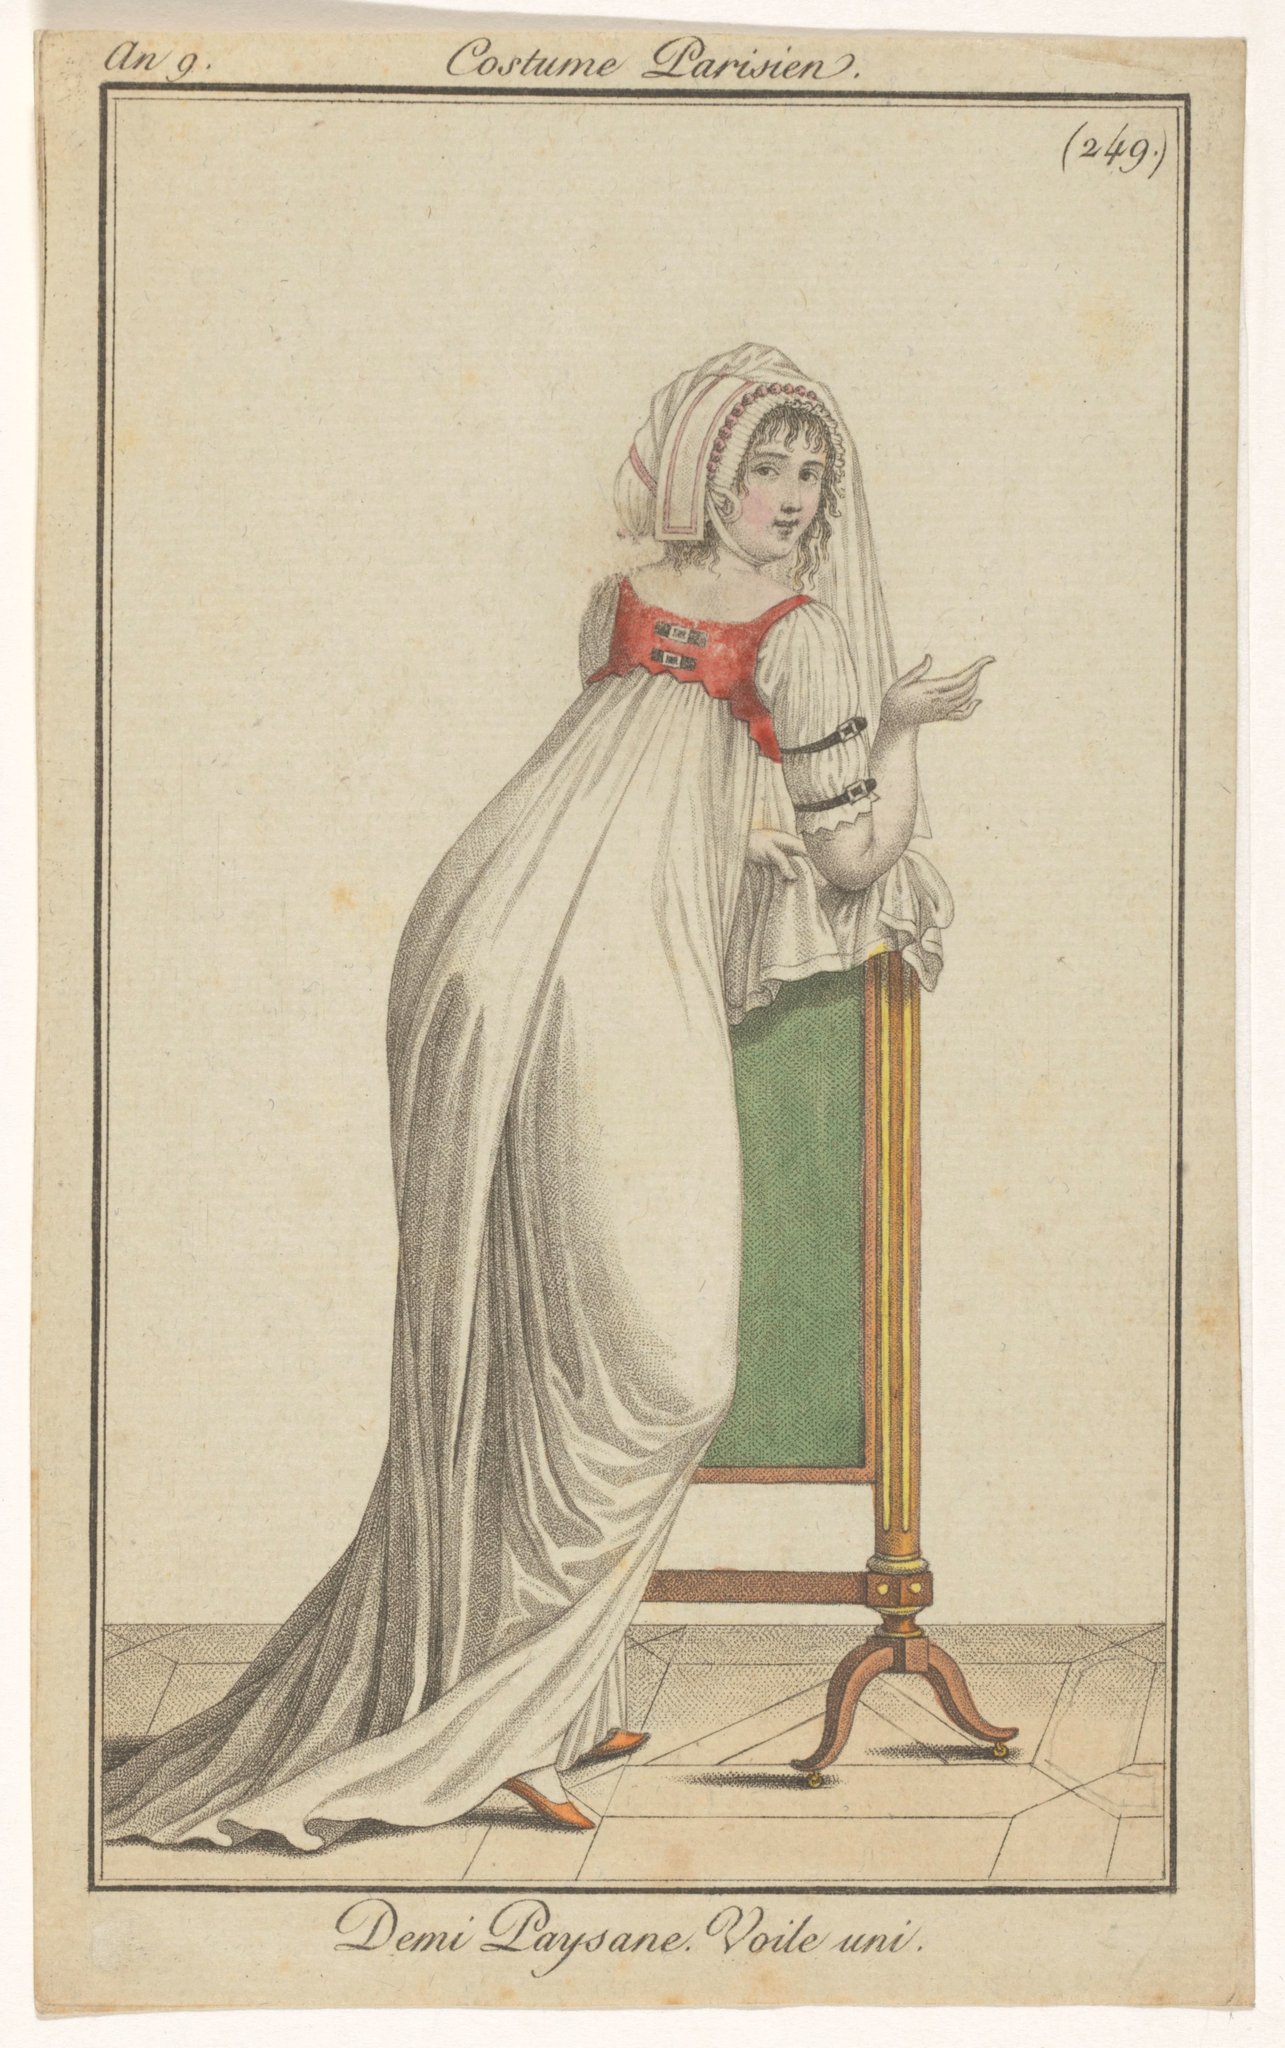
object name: fashion print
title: Demi Paysane. Voile uni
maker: Anonymous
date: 1800-1801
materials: paper, ink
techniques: etching, hand coloring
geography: france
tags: fashion plates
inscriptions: collector's mark: Lugt 2228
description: Kostuum van een jonge vrouw, voorover gebogen staand, op de rug gezien. Prent genomen uit het modetijdschrift Journal des Dames et des Modes, Costume Parisien, An 9 [1800-1801], nr. 249.